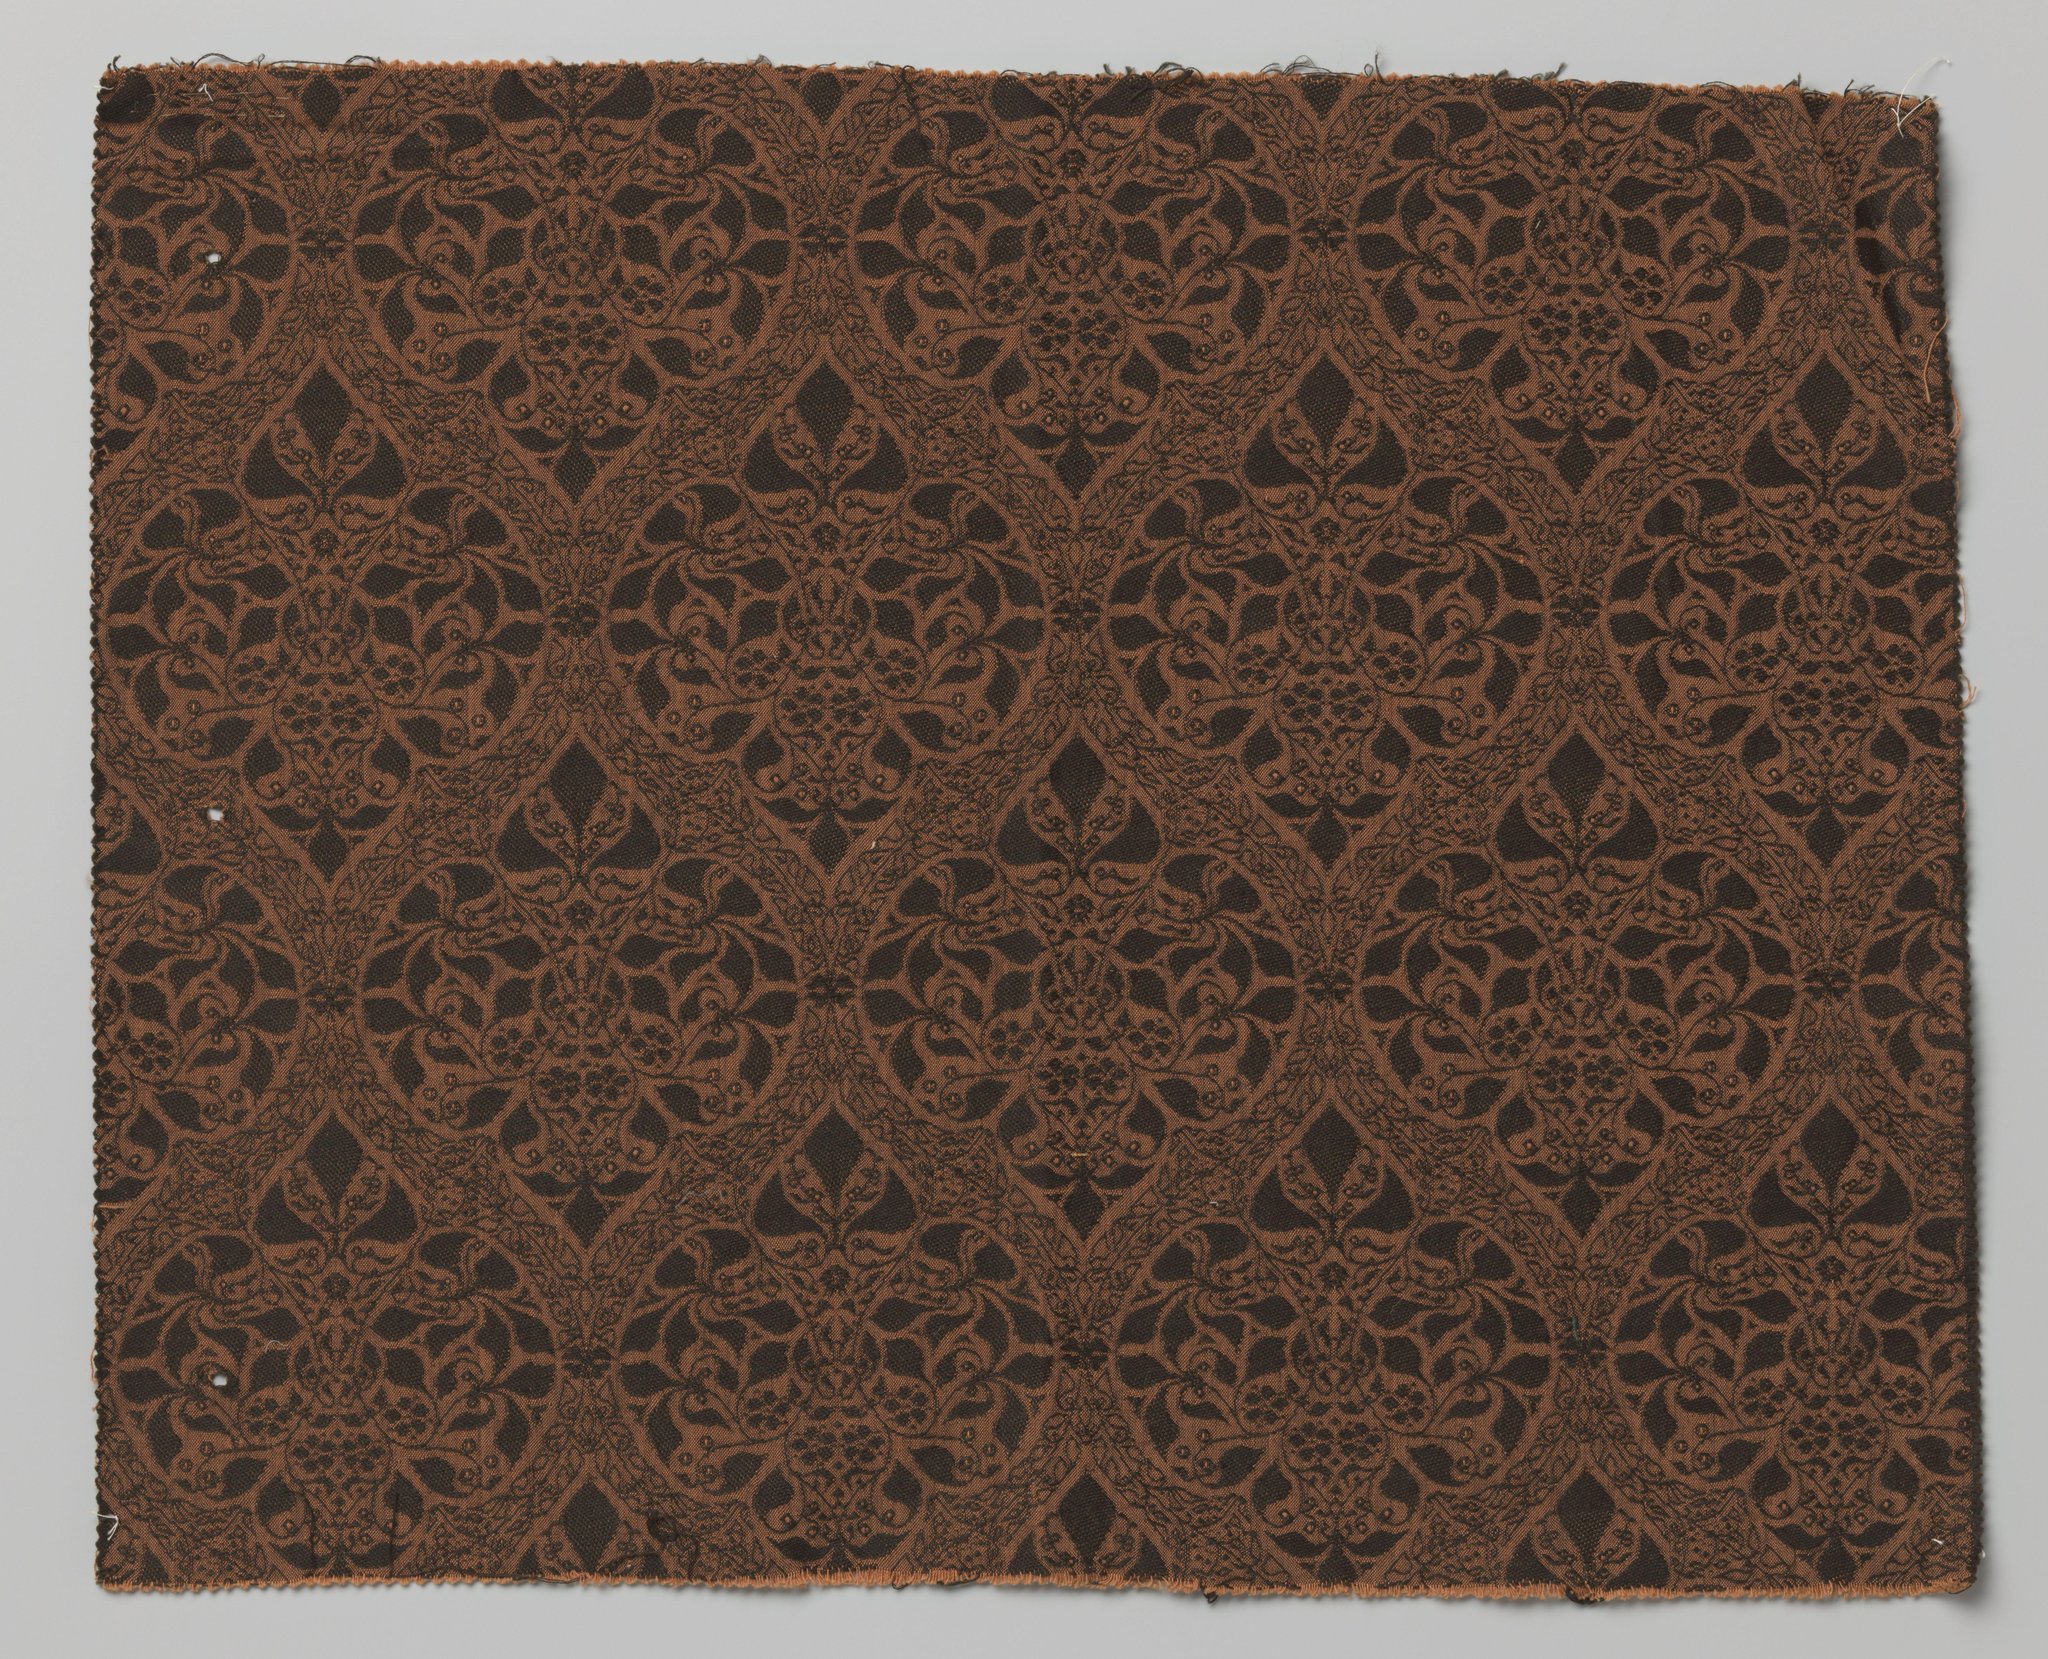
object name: upholstery fabric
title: Bespanningsstof met patroon van bladeren en bloemen binnen spitsovale banden van blaadjes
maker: theo nieuwenhuis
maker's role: designer, draughtsman, print maker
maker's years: 1866-1951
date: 1909-1924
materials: cotton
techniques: jacquard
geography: netherlands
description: Bespanningsstof met patroon van bladeren en bloemen binnen spitsovale banden van blaadjes. Bruinzwarte inslag op mokkakleurige inslag.